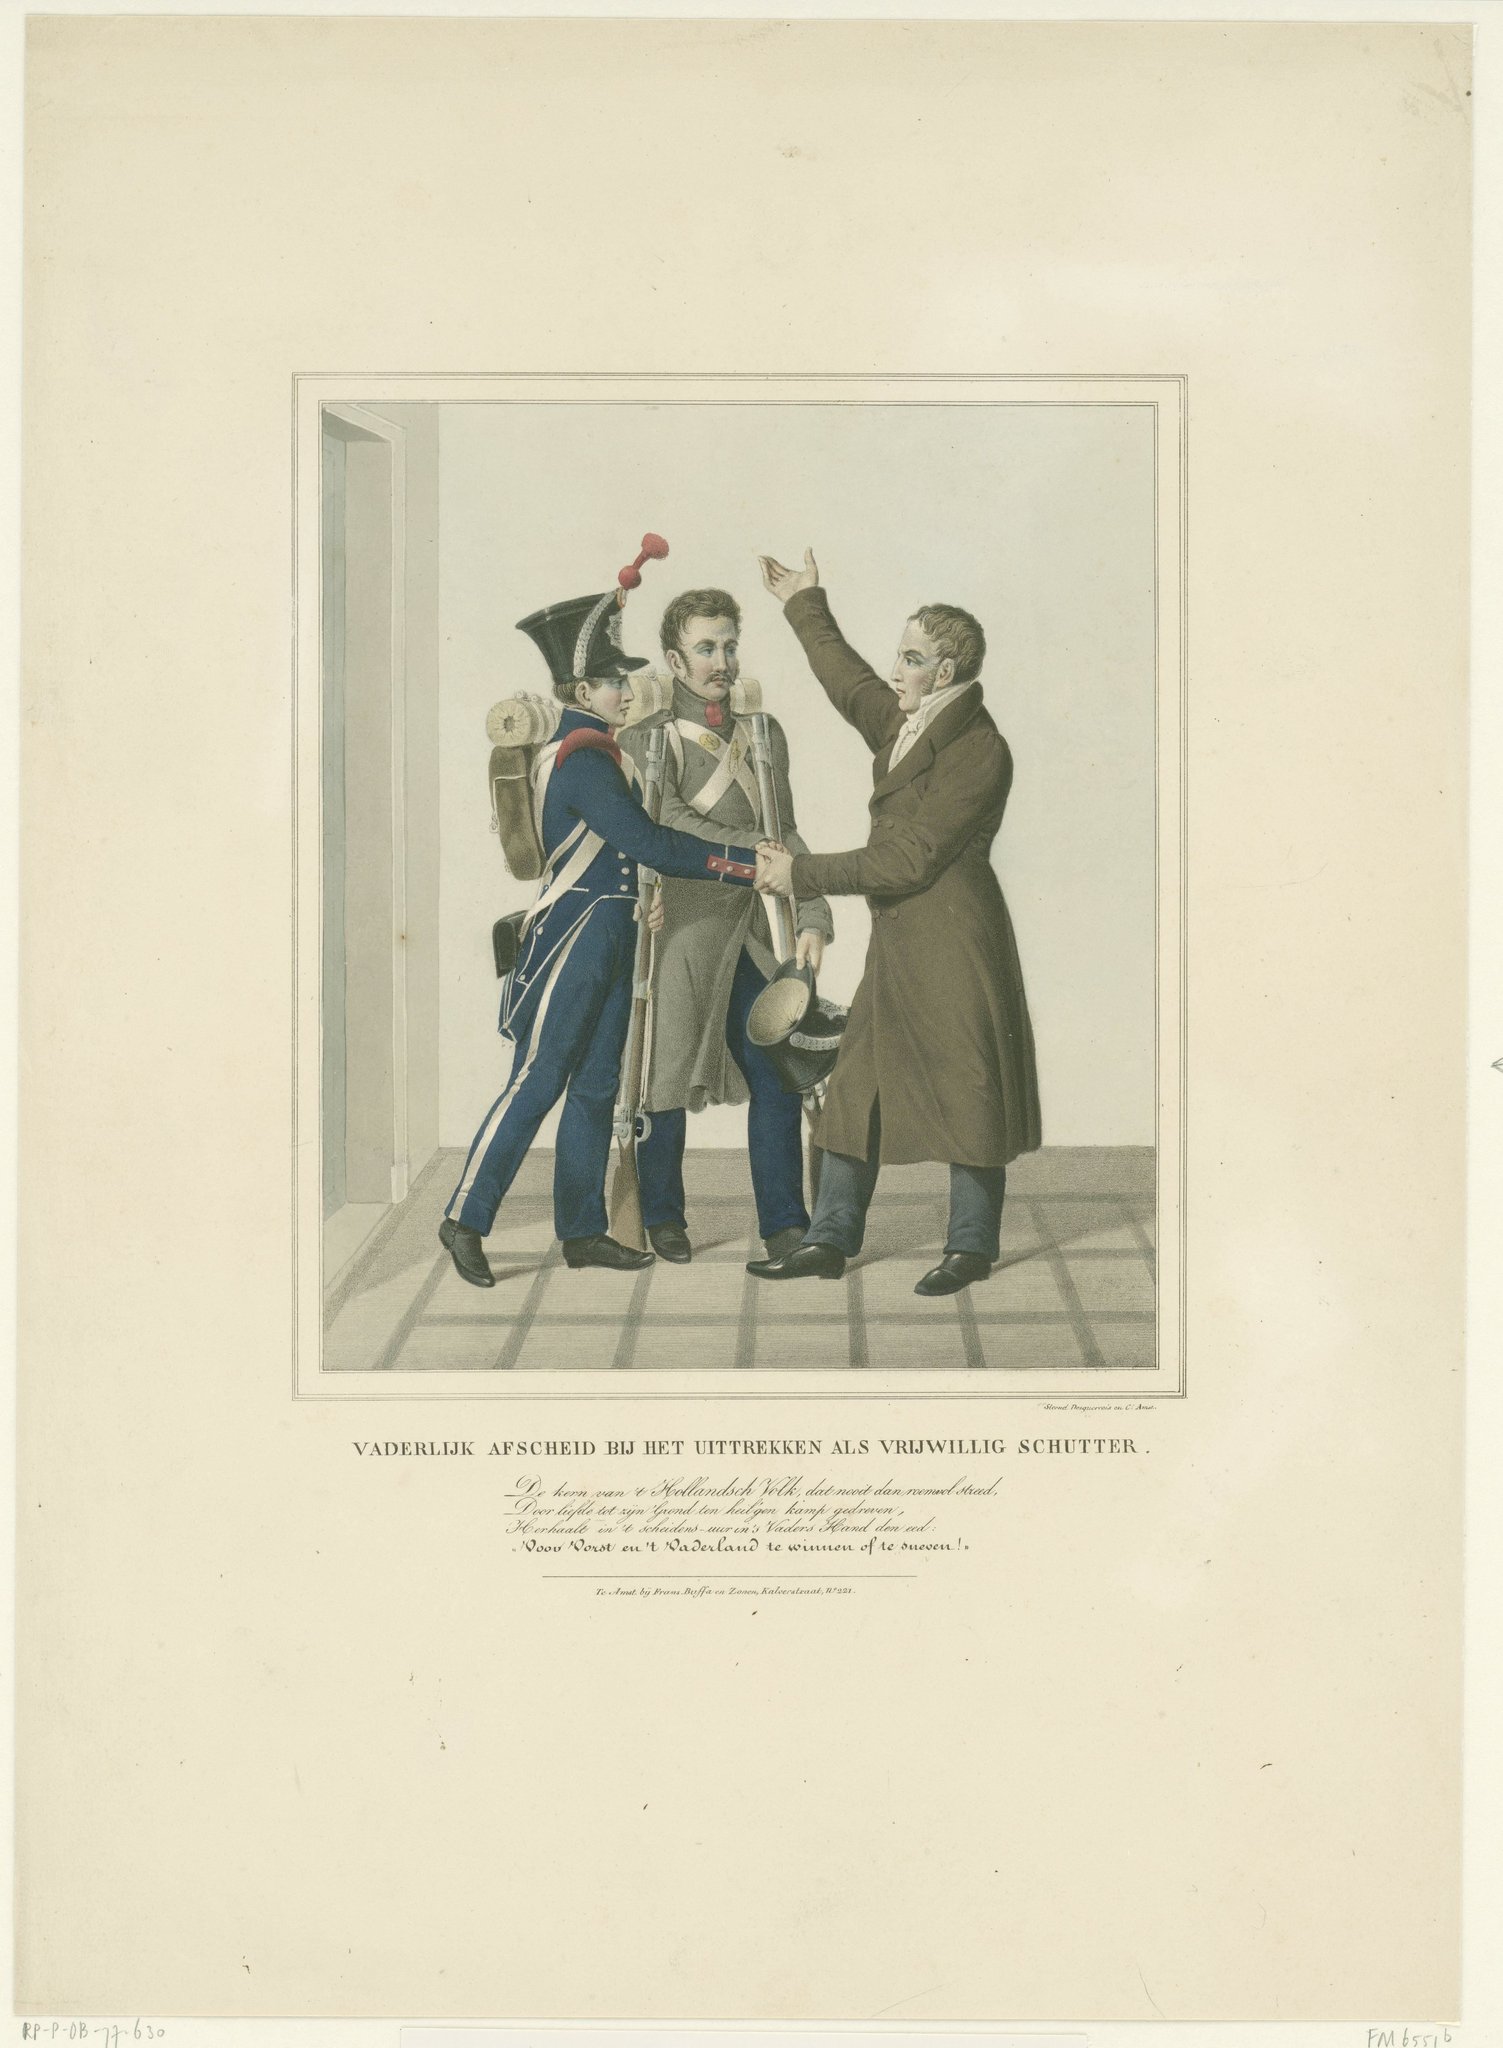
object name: print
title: Vaderlijk afscheid bij het uittrekken als vrijwillige schutter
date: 1830-1831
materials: paper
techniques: hand coloring, lithograph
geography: amsterdam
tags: leave-taking (of soldiers), waving farewell ~ departure on a journey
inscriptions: collector's mark: Lugt 2228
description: Een Nederlandse vrijwillige schutter schudt de hand en neemt afscheid van zijn vader, ca. oktober 1830. In het onderschrift een vierregelig vers.